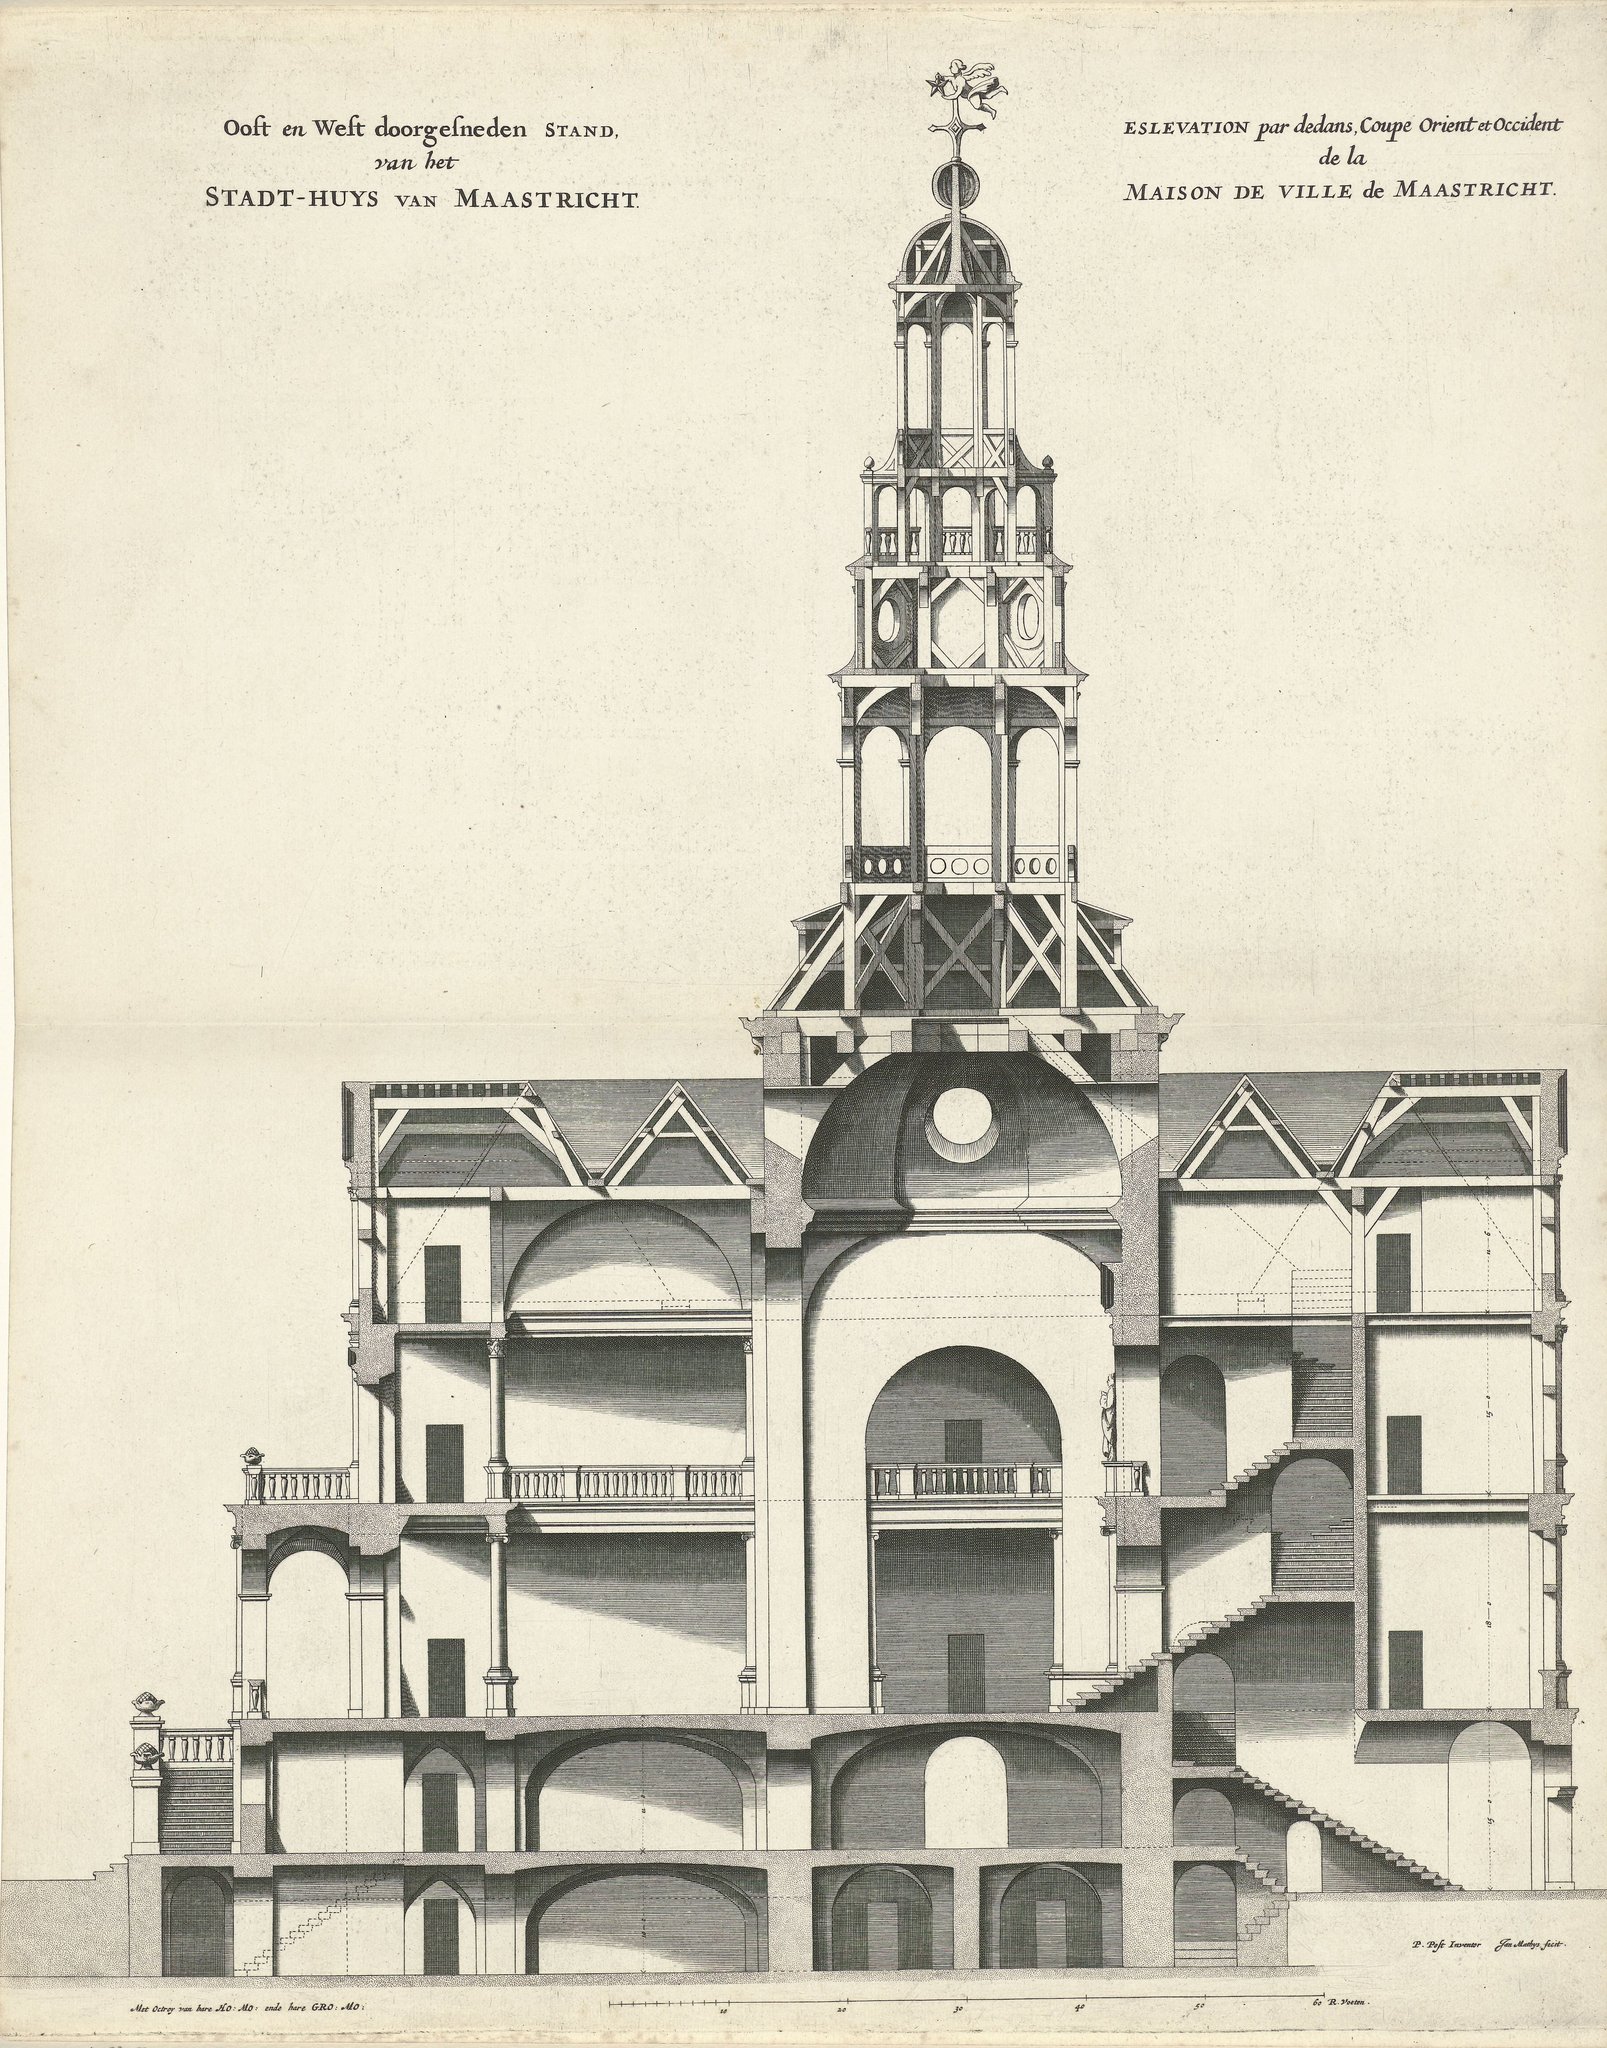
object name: print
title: Stadhuis van Maastricht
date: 1664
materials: paper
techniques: engraving, etching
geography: amsterdam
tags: townhall, section ~ architectural design or model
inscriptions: collector's mark: Lugt 2228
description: Oost-west doorsnede van het stadhuis van Maastricht met links de toegangstrap.